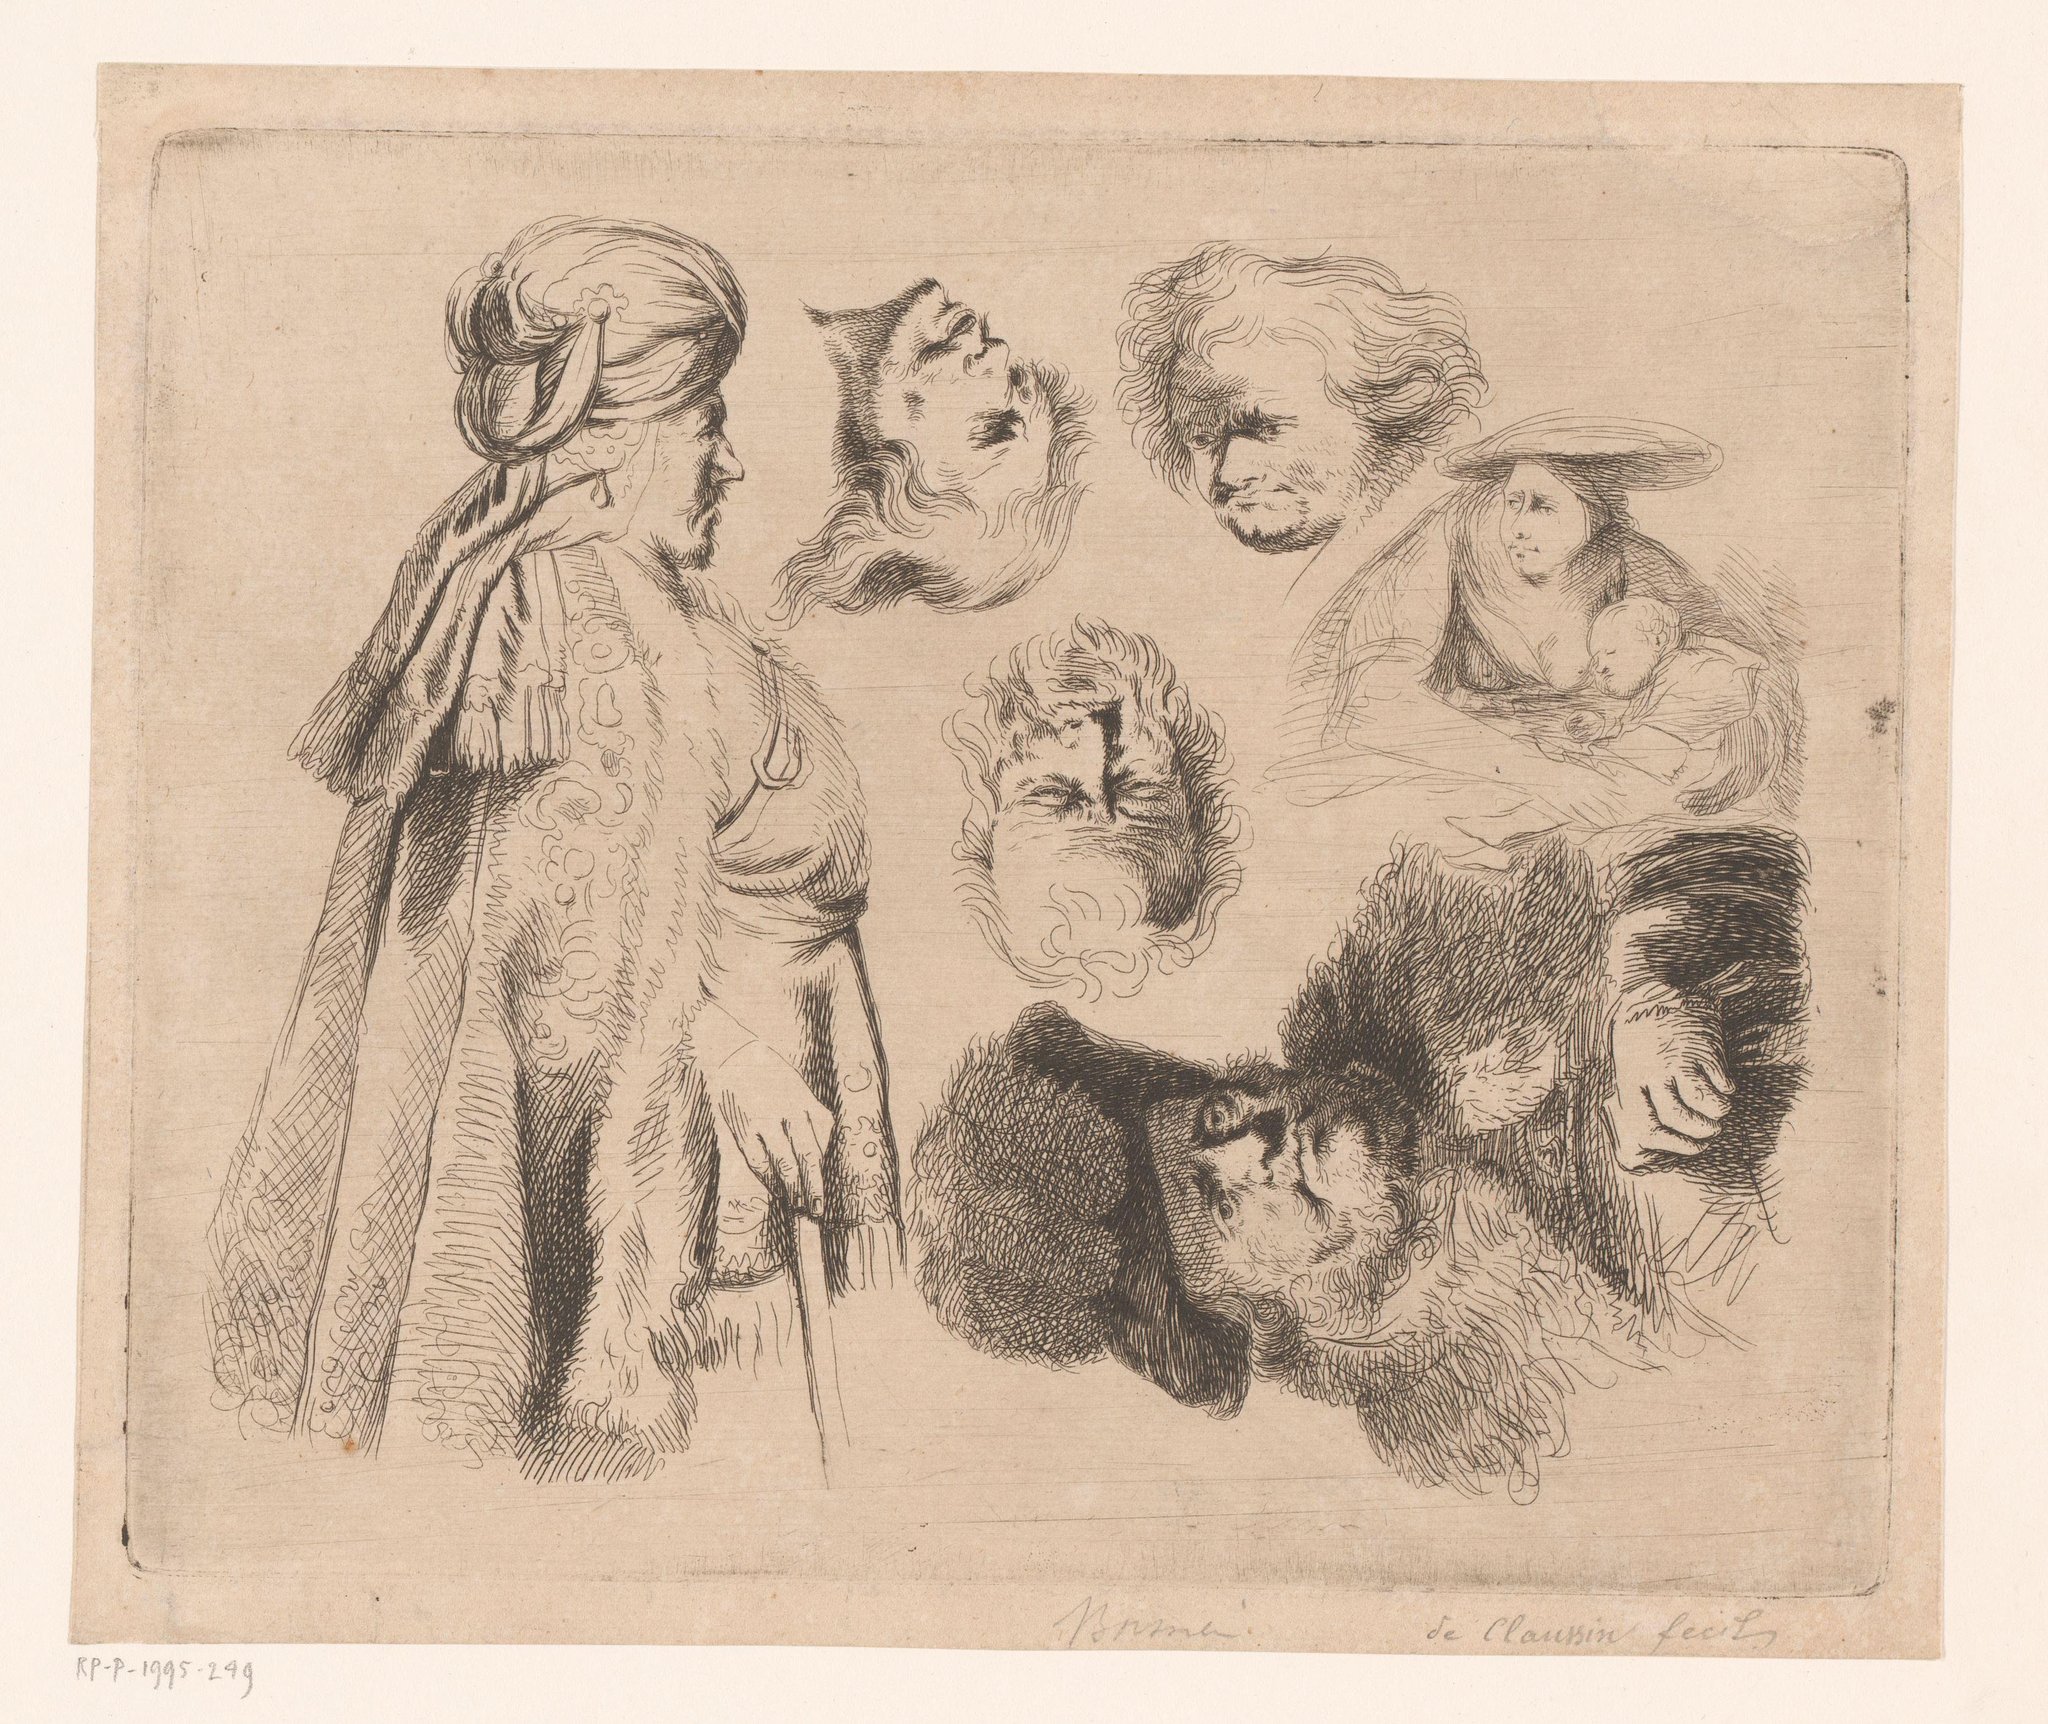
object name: print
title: Compositie met Oosterse man, vrouw met kind en vier hoofden van mannen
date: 1805-1844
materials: paper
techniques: drypoint, engraving, etching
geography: france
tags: head (human), head-gear: turban, mother and child(ren), woman and child(ren) (family group)